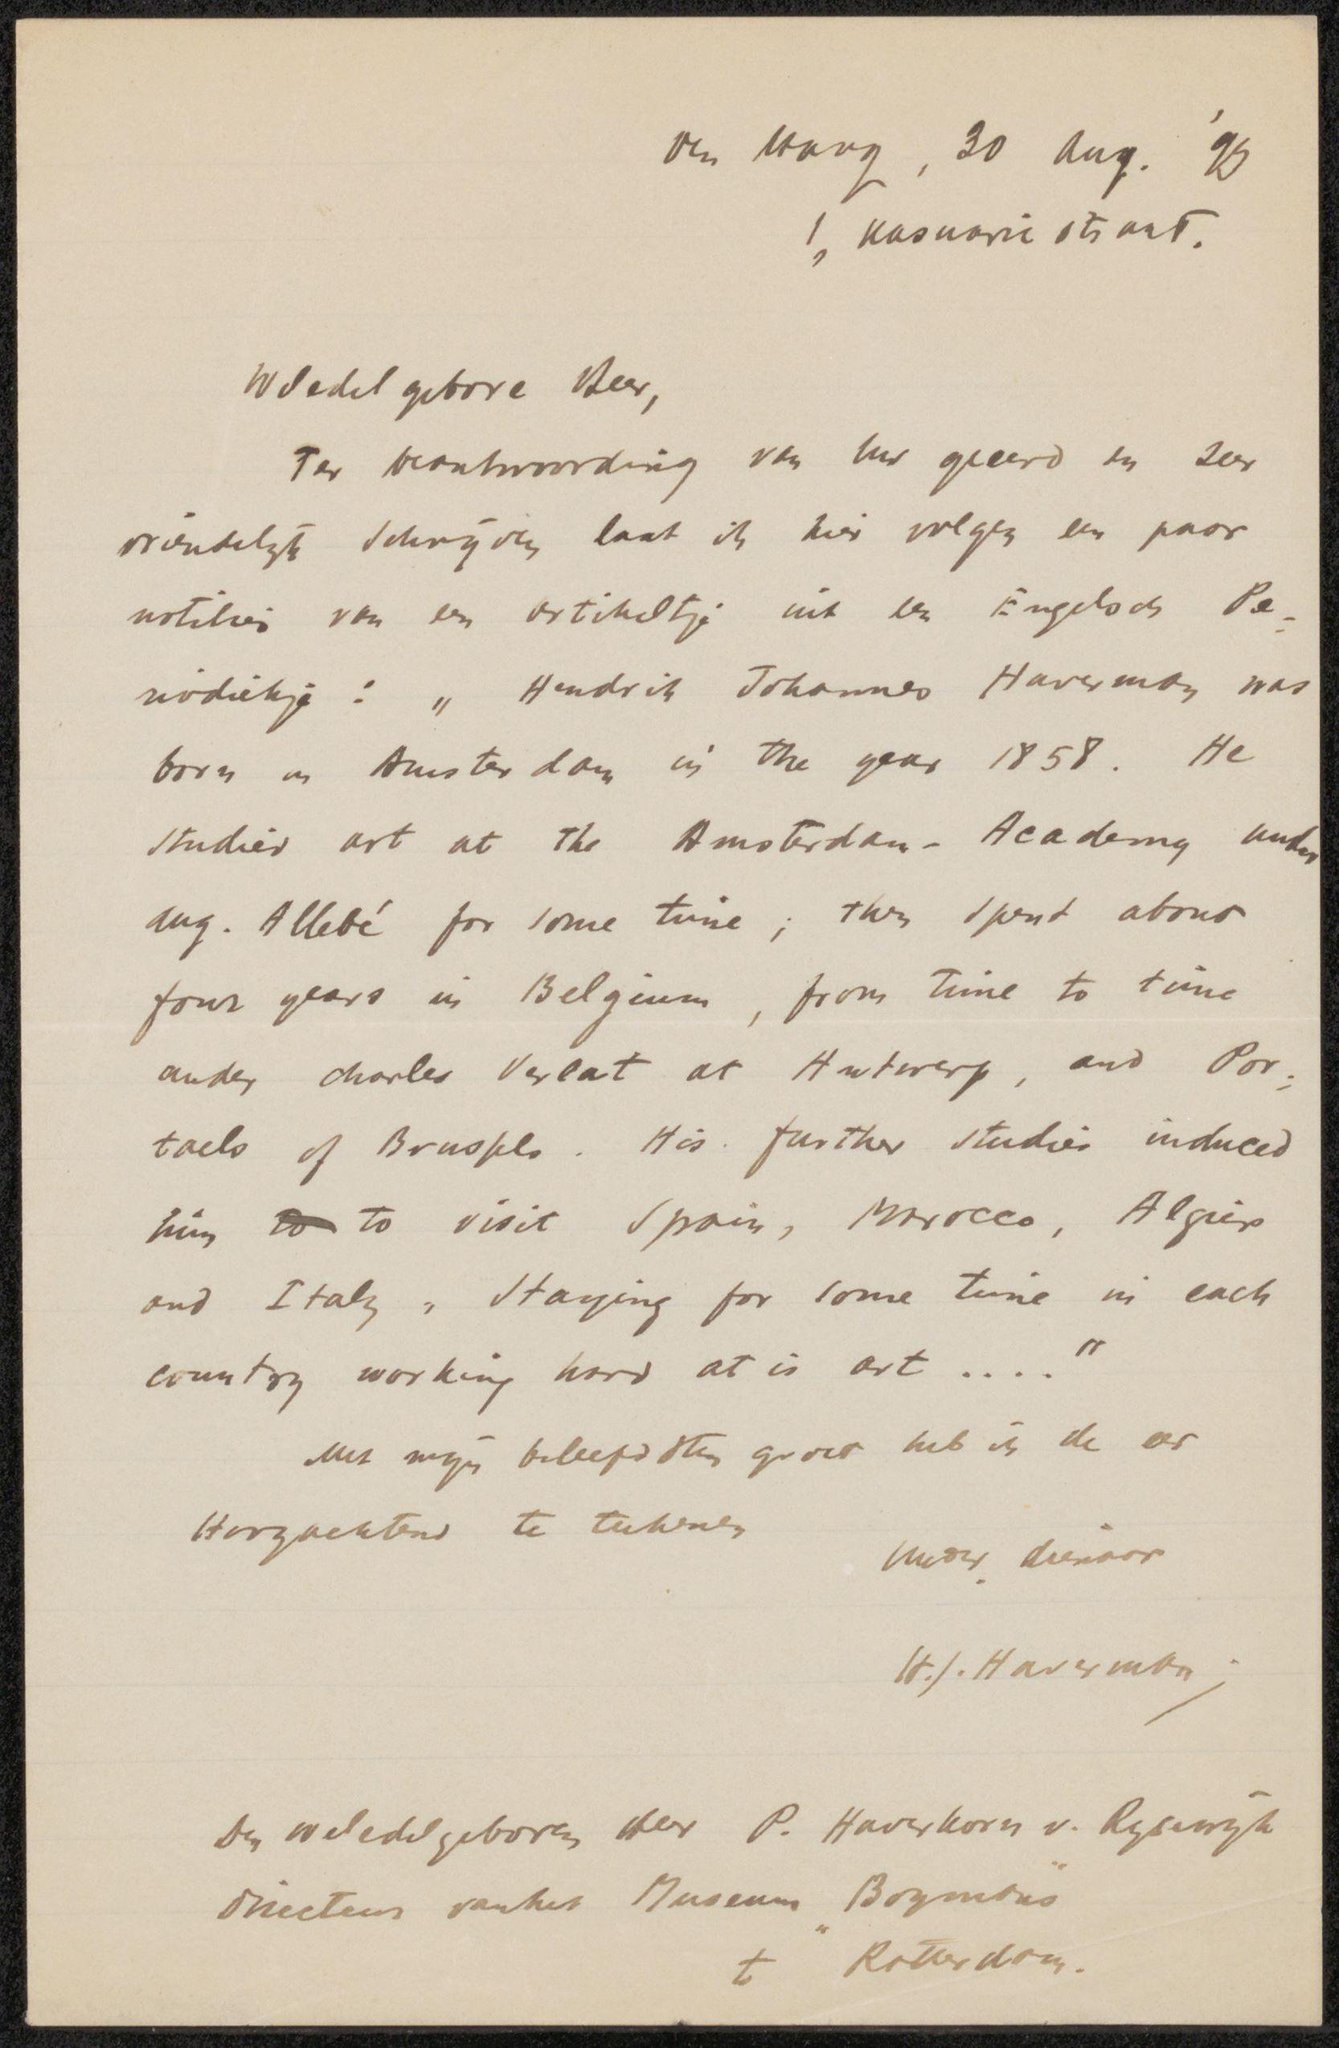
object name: letter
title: Brief aan Pieter Haverkorn van Rijsewijk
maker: hendrik johannes haverman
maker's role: draughtsman, print maker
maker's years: 1857-1928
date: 1899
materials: ink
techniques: pen, writing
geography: the hague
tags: august allebé, pieter haverkorn van rijsewijk, education, tuition of the artist (in general), italy, spain, belgium